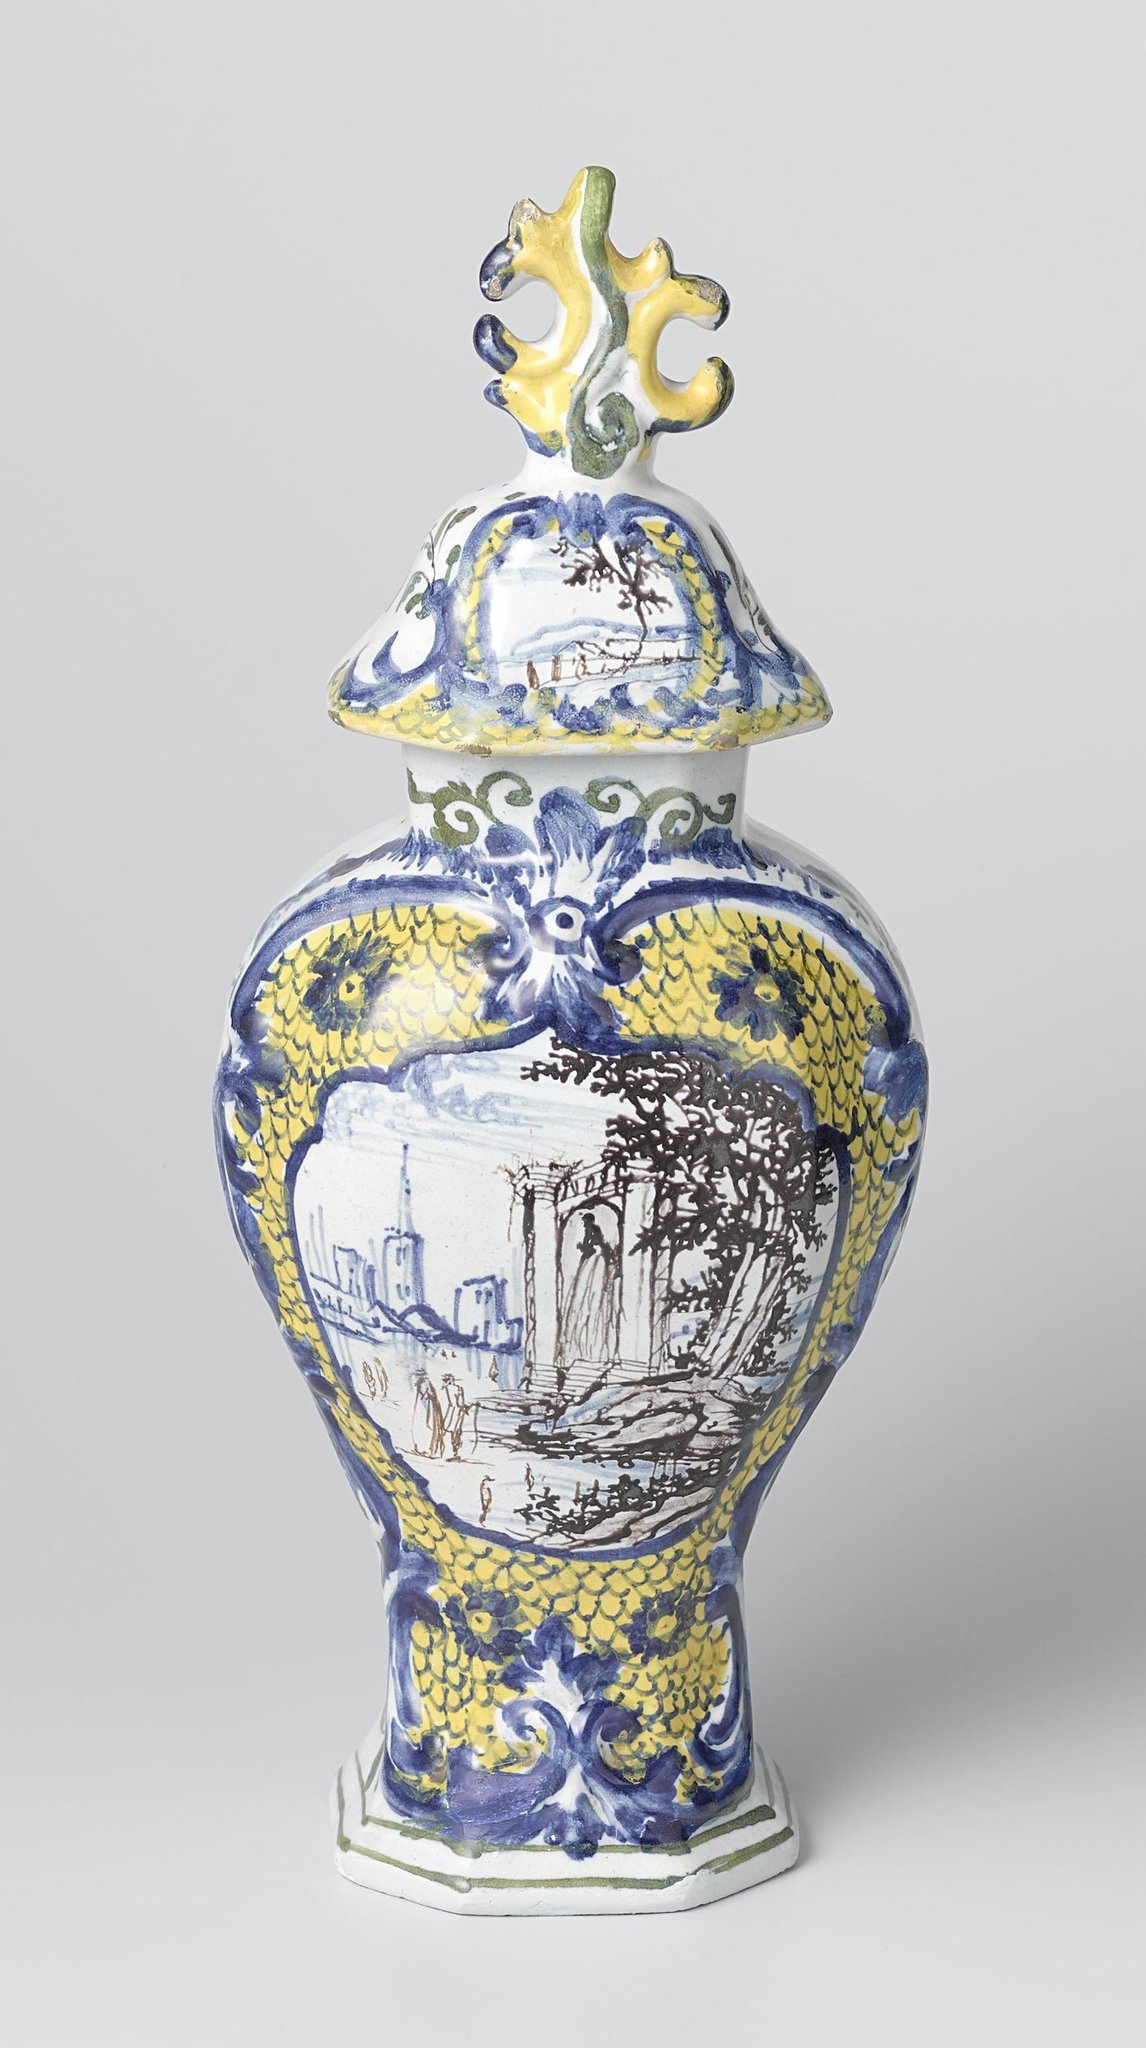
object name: kaststel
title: Pot met deksel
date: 1780-1820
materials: faience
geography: delft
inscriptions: mark: ‘B:P’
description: Pot met deksel van faience. Veelkleurig beschilderd. De pot is gemerkt: B-P.